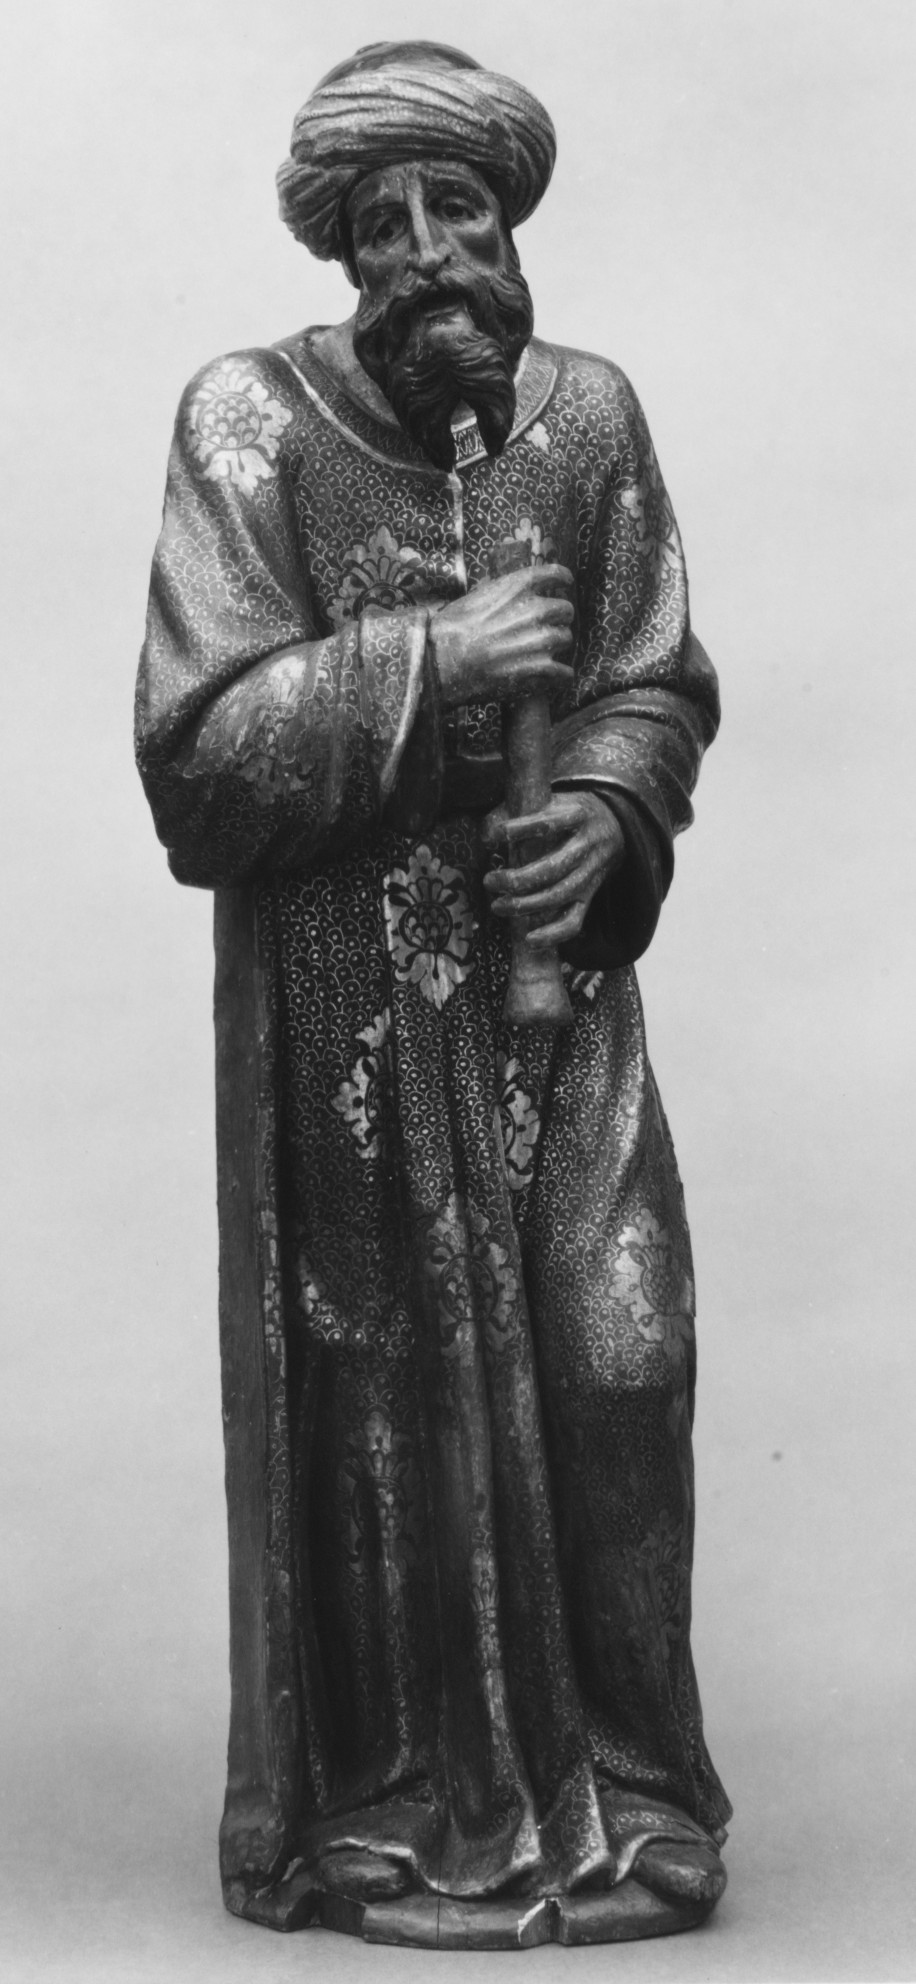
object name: statue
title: Magus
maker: francisco giralte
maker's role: artist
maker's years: 1500-1576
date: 1534-1566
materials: wood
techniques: carving, gilding, painting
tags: men